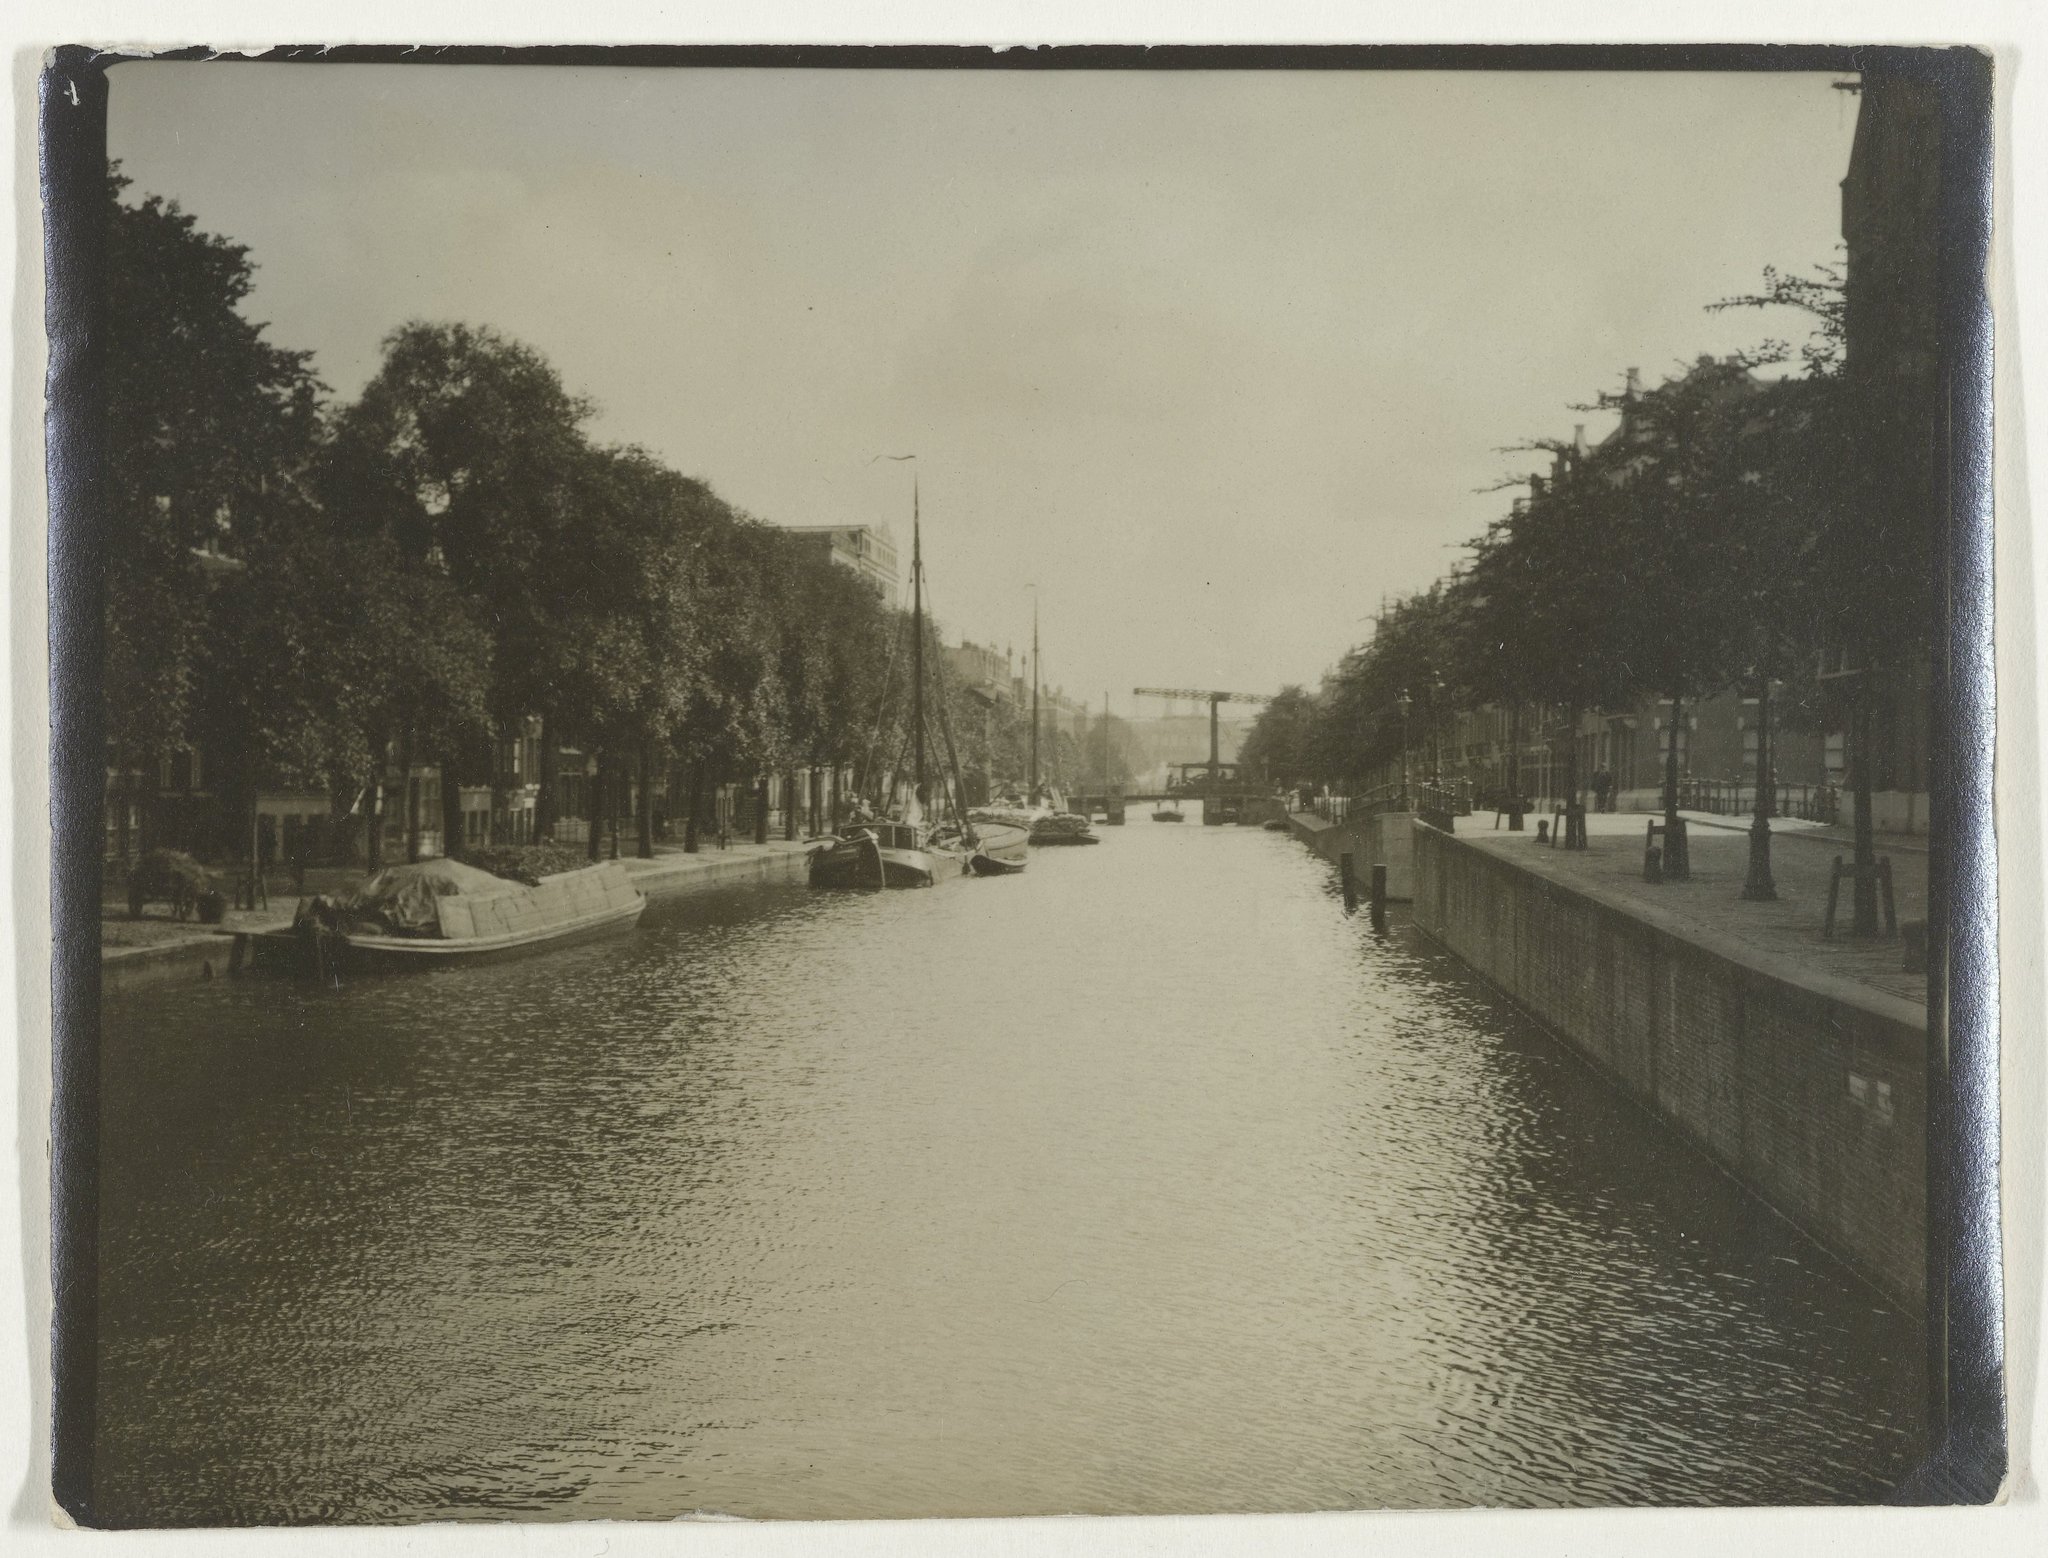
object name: photograph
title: Gracht in Amsterdam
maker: Anonymous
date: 1900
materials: photographic support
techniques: gelatin silver print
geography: amsterdam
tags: canals, waters (in city), amsterdam